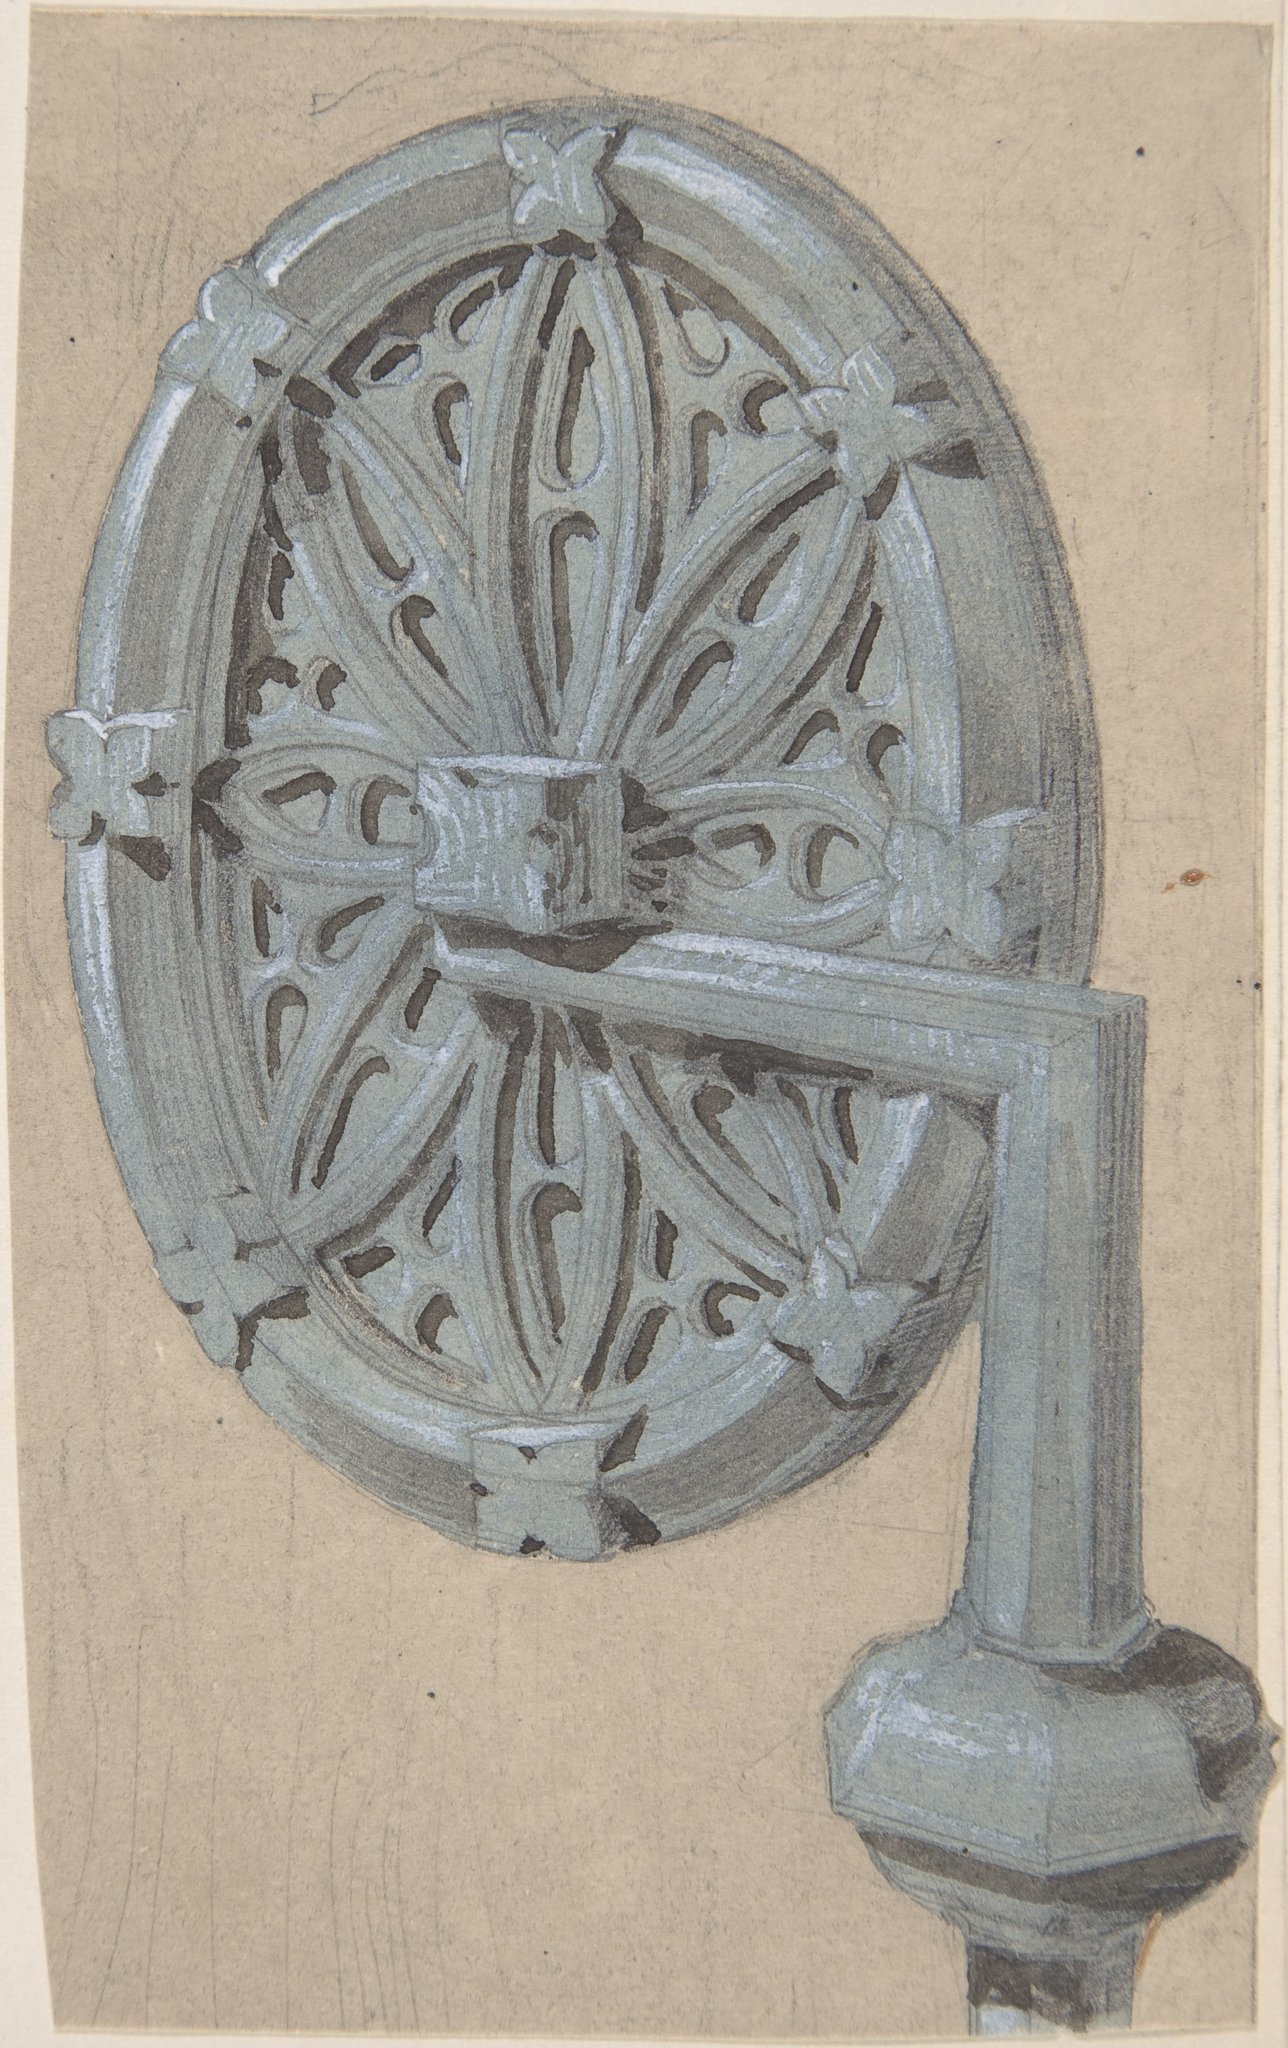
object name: drawing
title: Metal Ecclesiastical Object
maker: anonymous, british, 19th century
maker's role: artist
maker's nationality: british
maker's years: 1800-1900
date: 1851-1900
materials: gouache